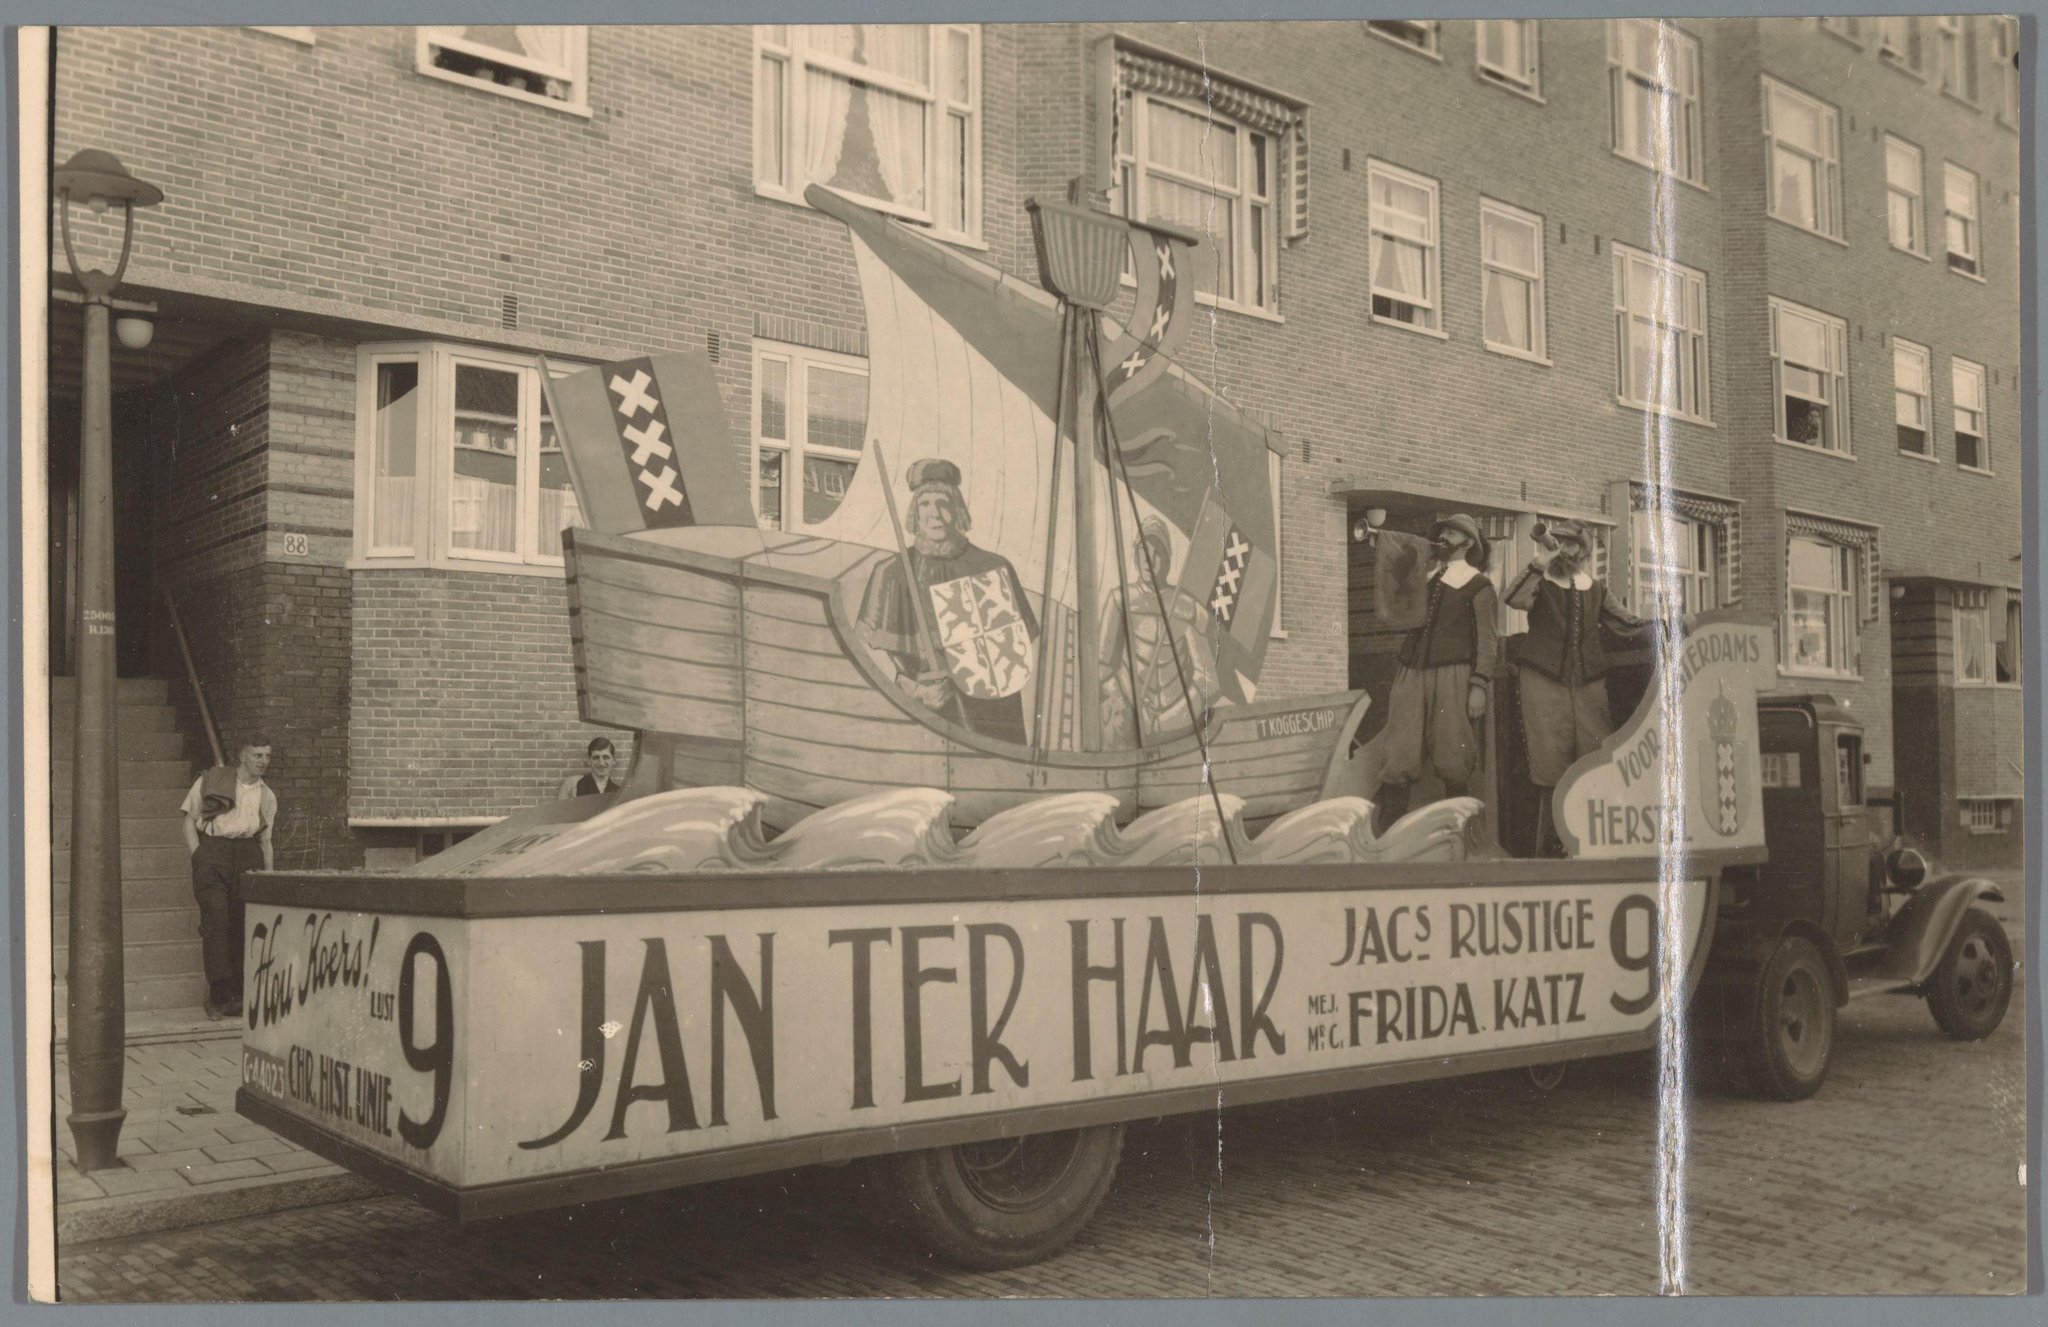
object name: photograph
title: Versierde wagen van de politieke partij Lijst 9 tijdens een optocht in Amsterdam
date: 1920-1940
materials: photographic support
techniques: gelatin silver print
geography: amsterdam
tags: public festivities (+ parade, pageant, cavalcade ~ festive activities), political parties, amsterdam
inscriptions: annotation: ‘Amsterdam/ 30er jaren’